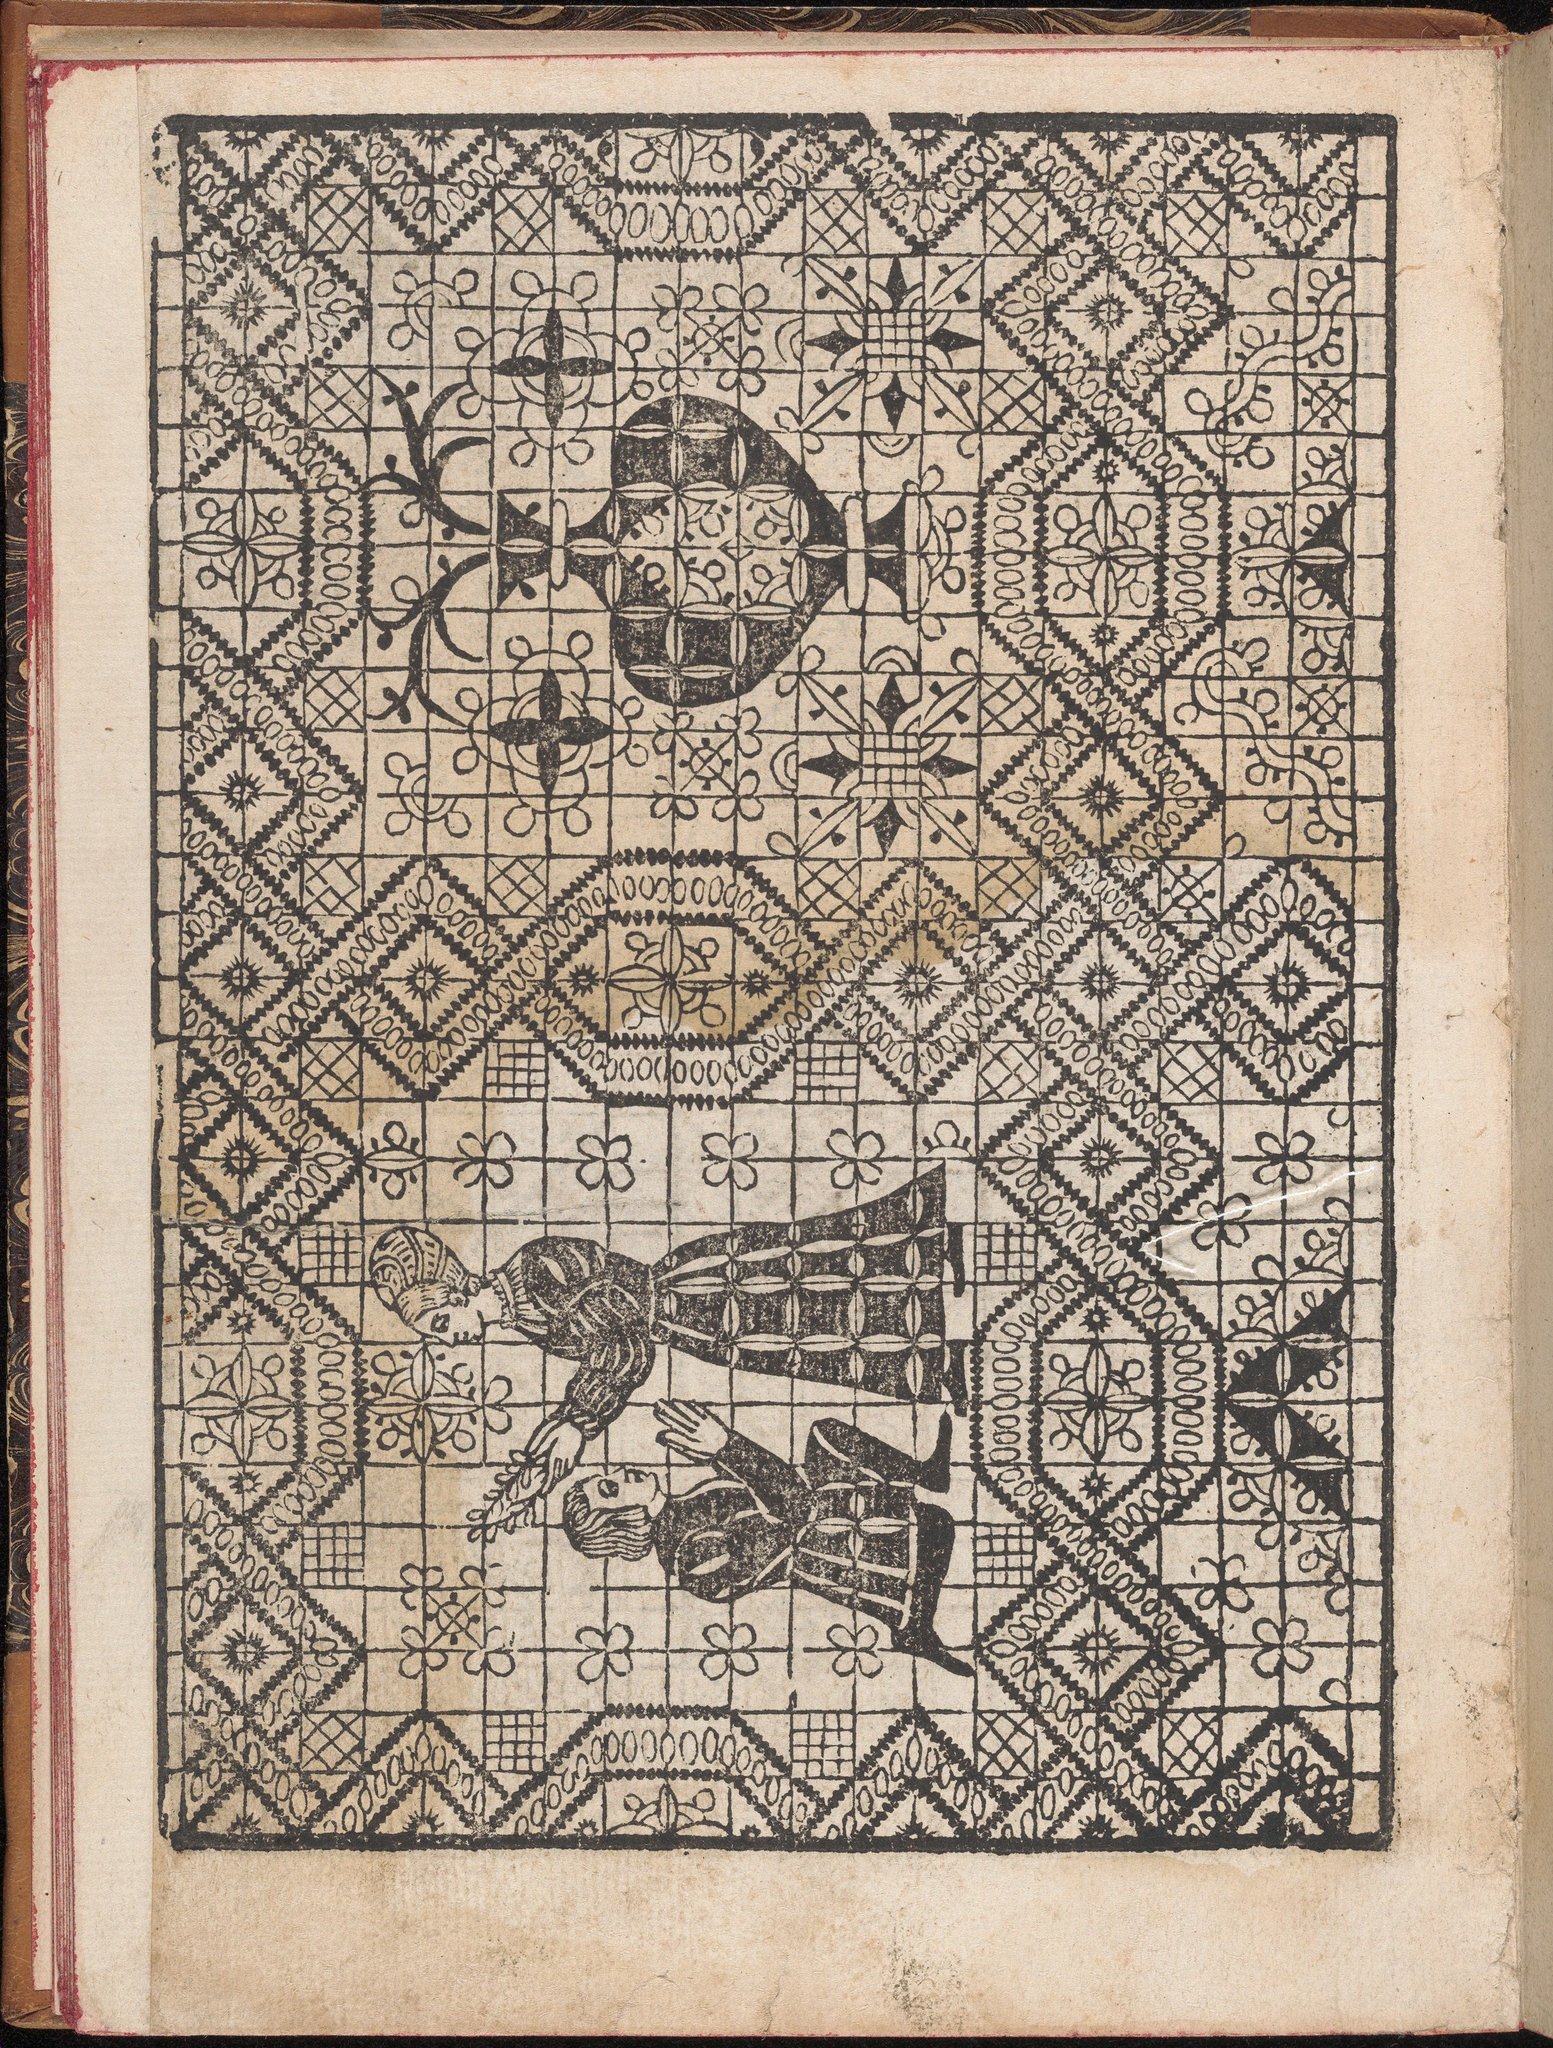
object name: book print ornament architecture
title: Spechio di pensieri delle belle et Virtudiose donne, page 8 (verso)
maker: matteo pagano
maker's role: publisher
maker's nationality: italian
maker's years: 1515-1588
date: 1546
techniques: woodcut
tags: ornament,men,women,vases